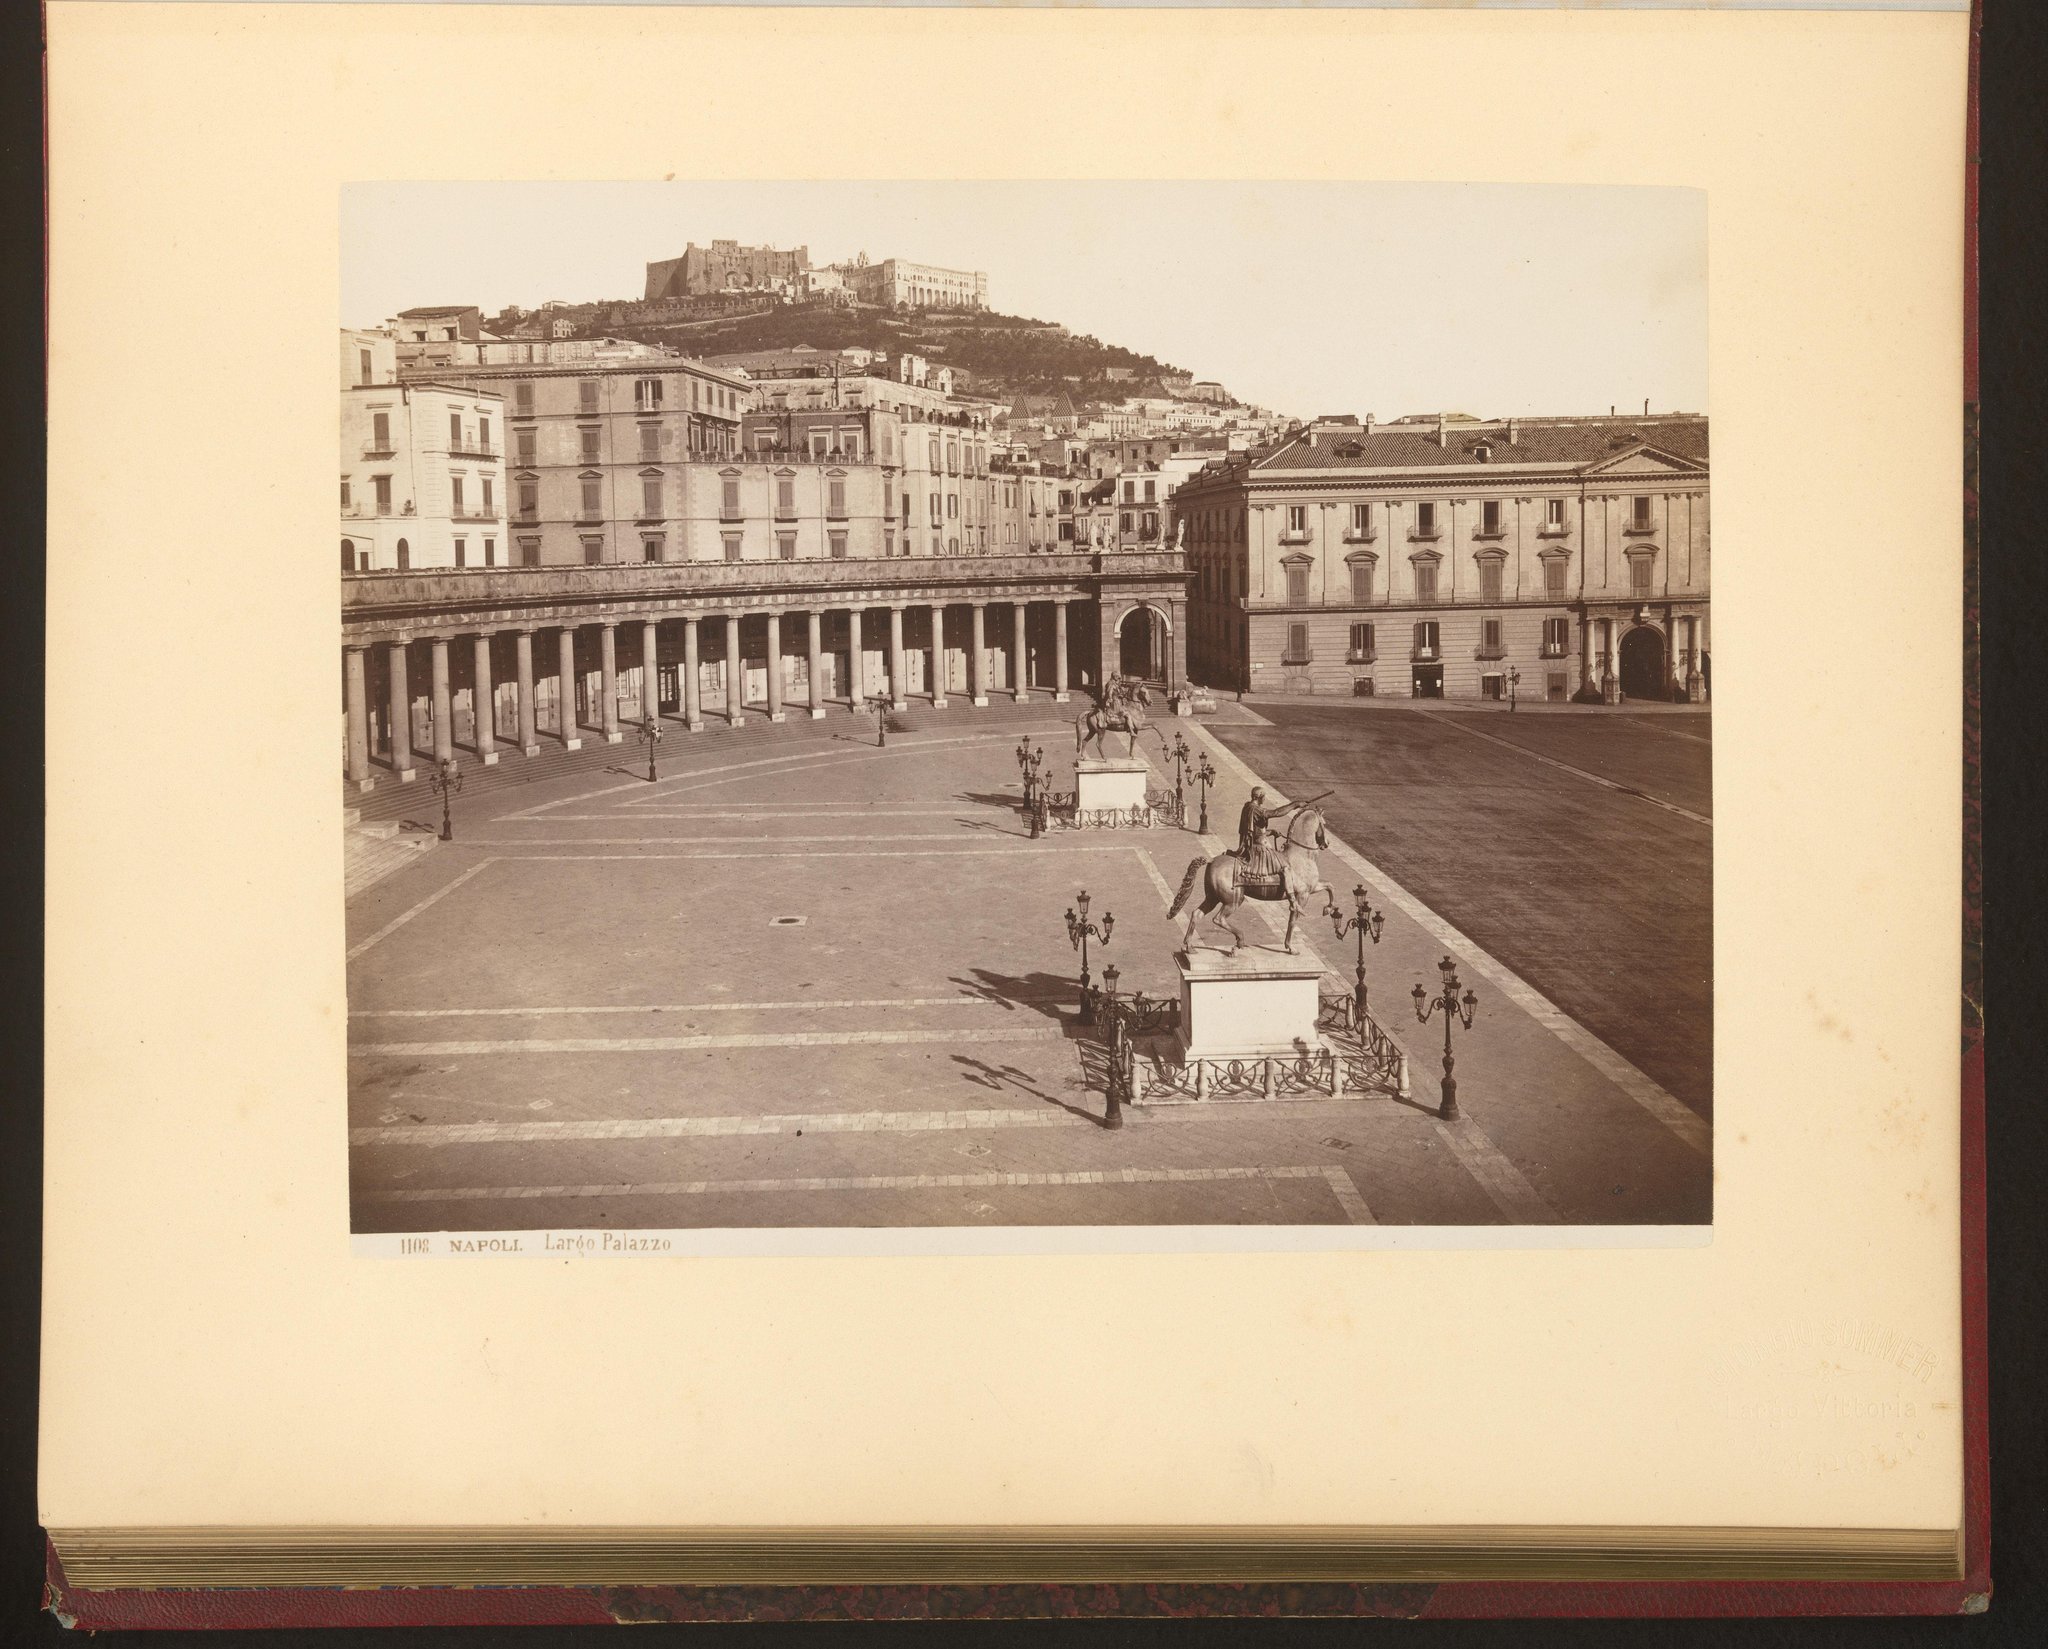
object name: photograph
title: Napoli - Largo Palazzo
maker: giorgio sommer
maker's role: fotograaf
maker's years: 1834-1914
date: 1874-1879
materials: photographic support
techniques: albumen print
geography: naples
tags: colonnade, monument, statue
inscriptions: number: ‘1108’, workshop stamp: ‘Giorgio Sommer/ Largo Vittoria/ Napoli’